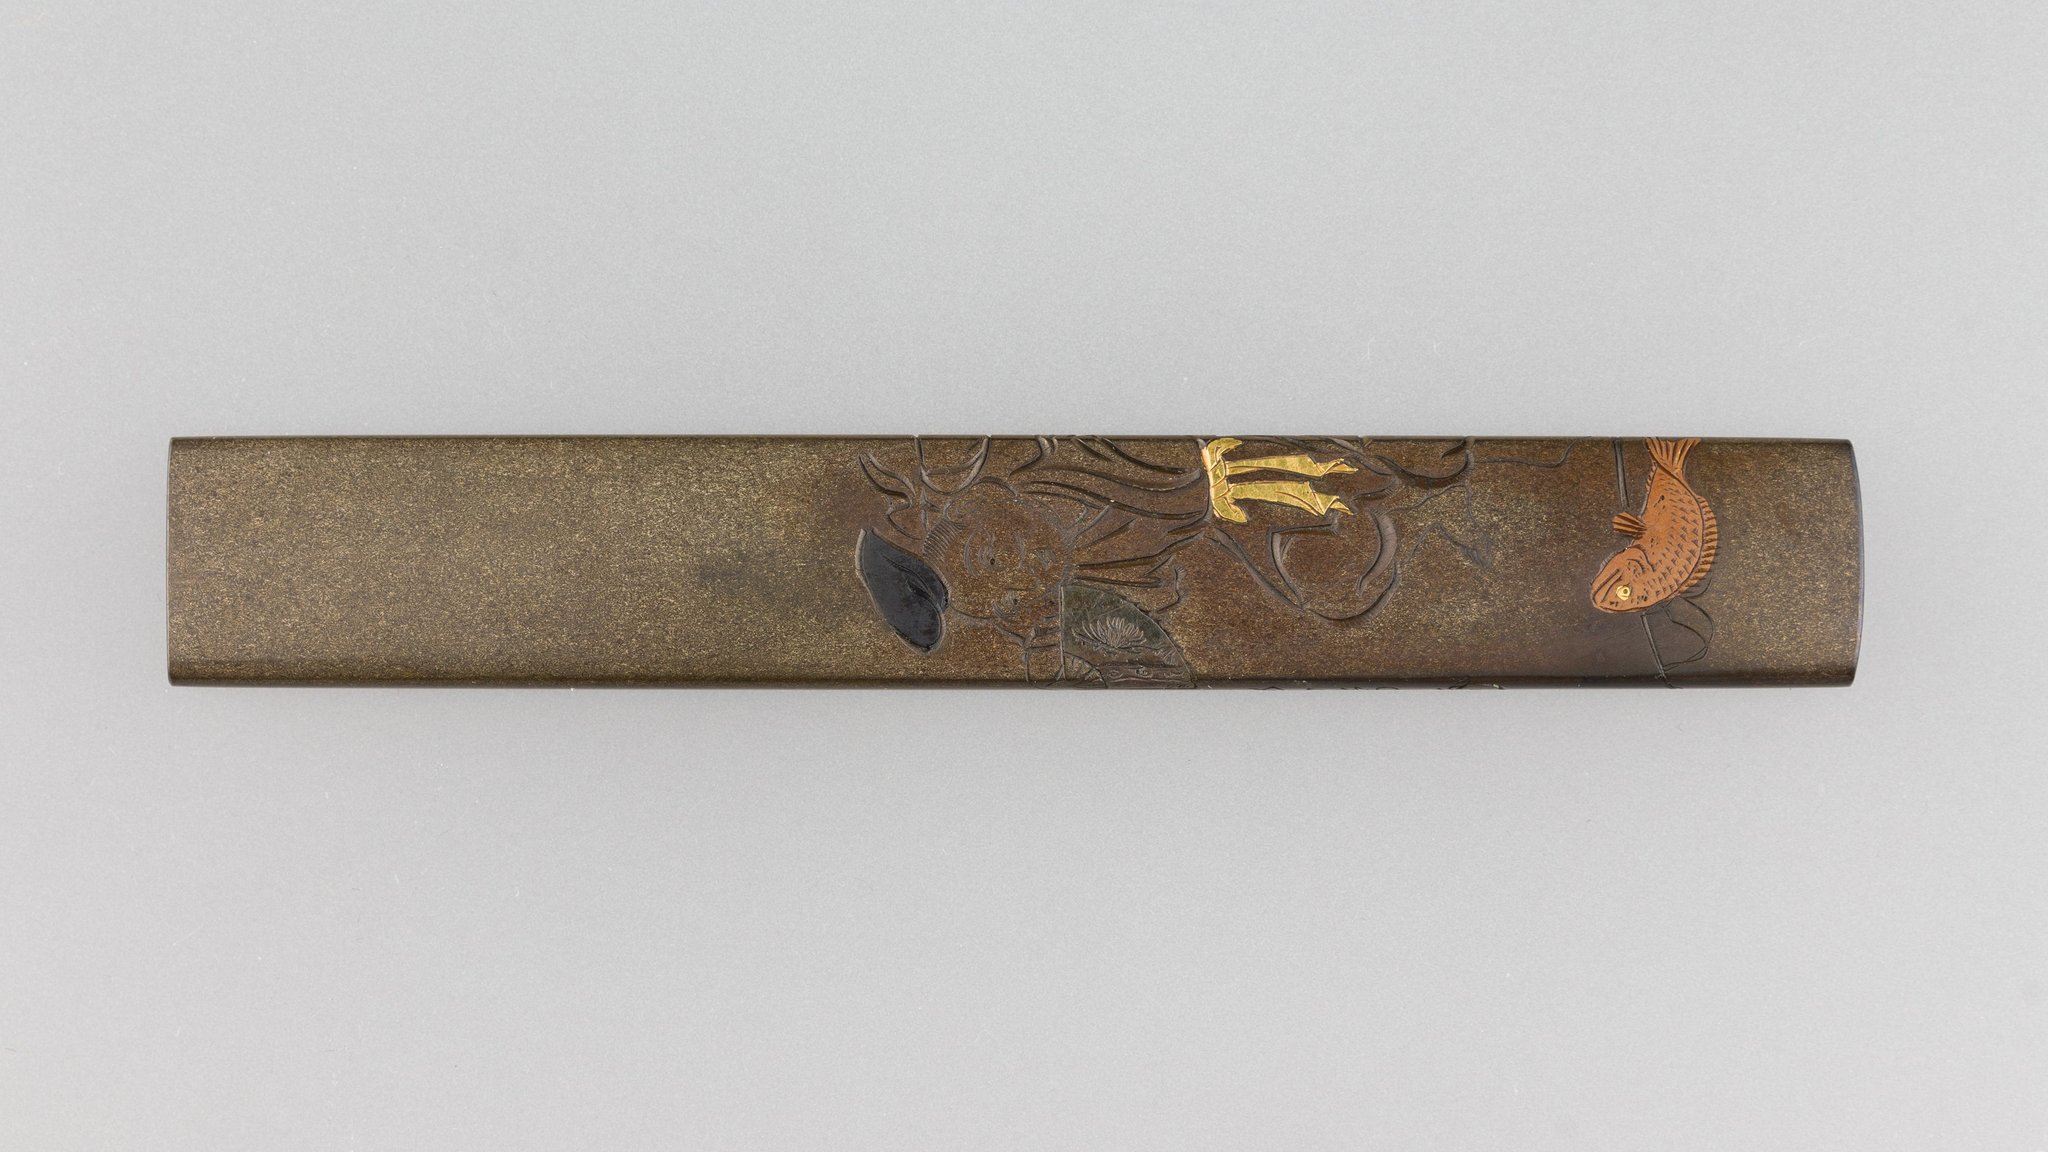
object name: knife handle kozuka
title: Knife Handle (Kozuka)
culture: japanese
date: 1701-1800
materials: copper, gold alloy, silver alloy, gold, silver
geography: japan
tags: men,fish